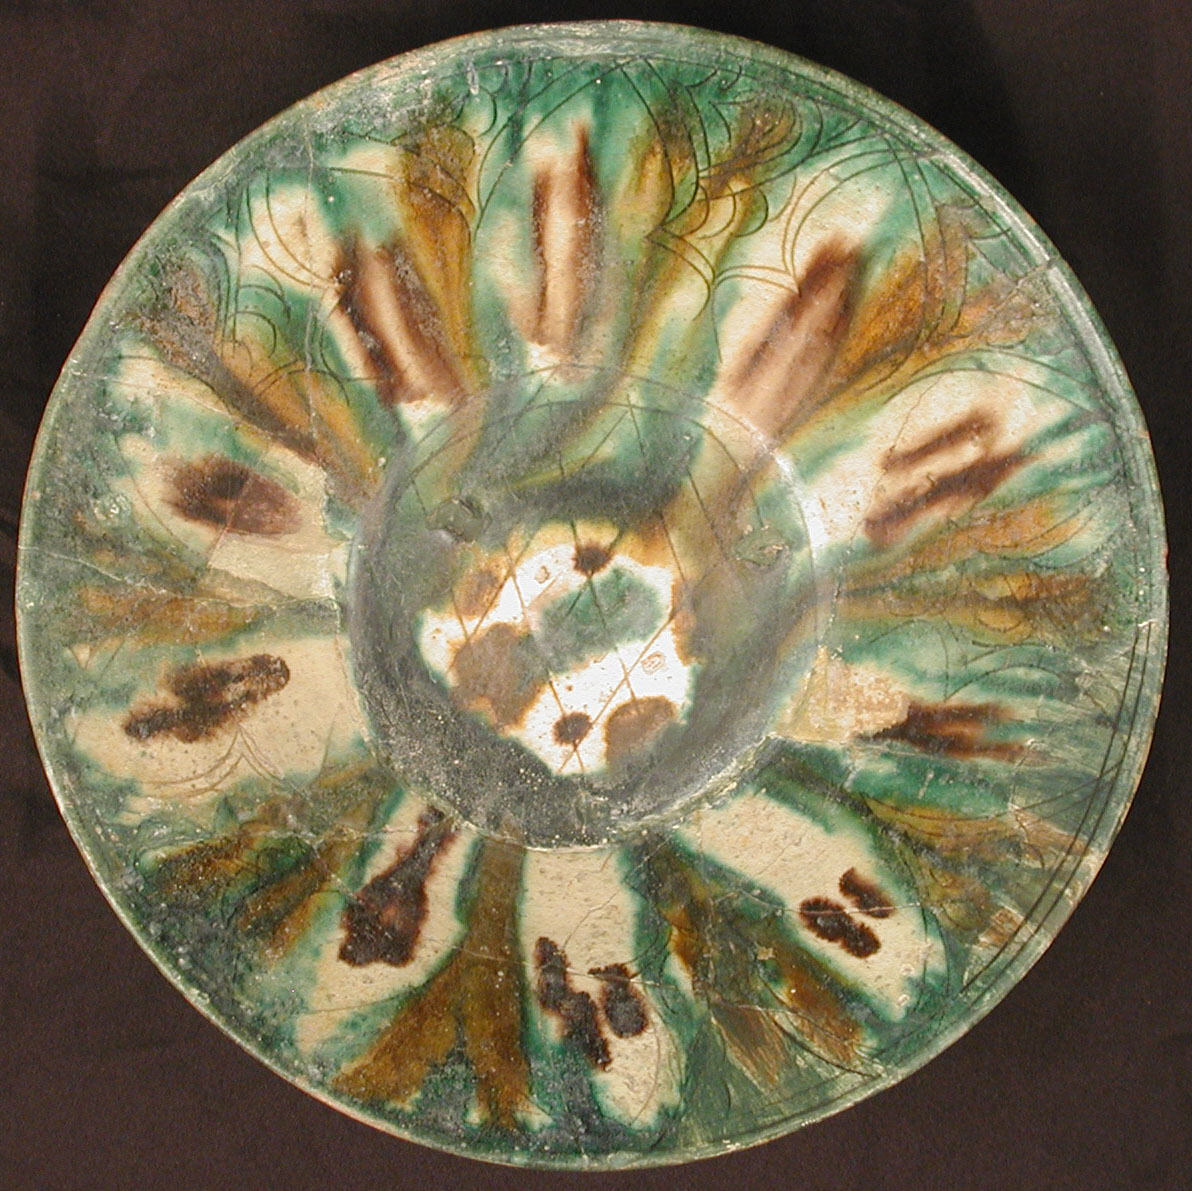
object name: bowl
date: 801-1000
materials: earthenware, glaze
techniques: incising, polychrome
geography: iran